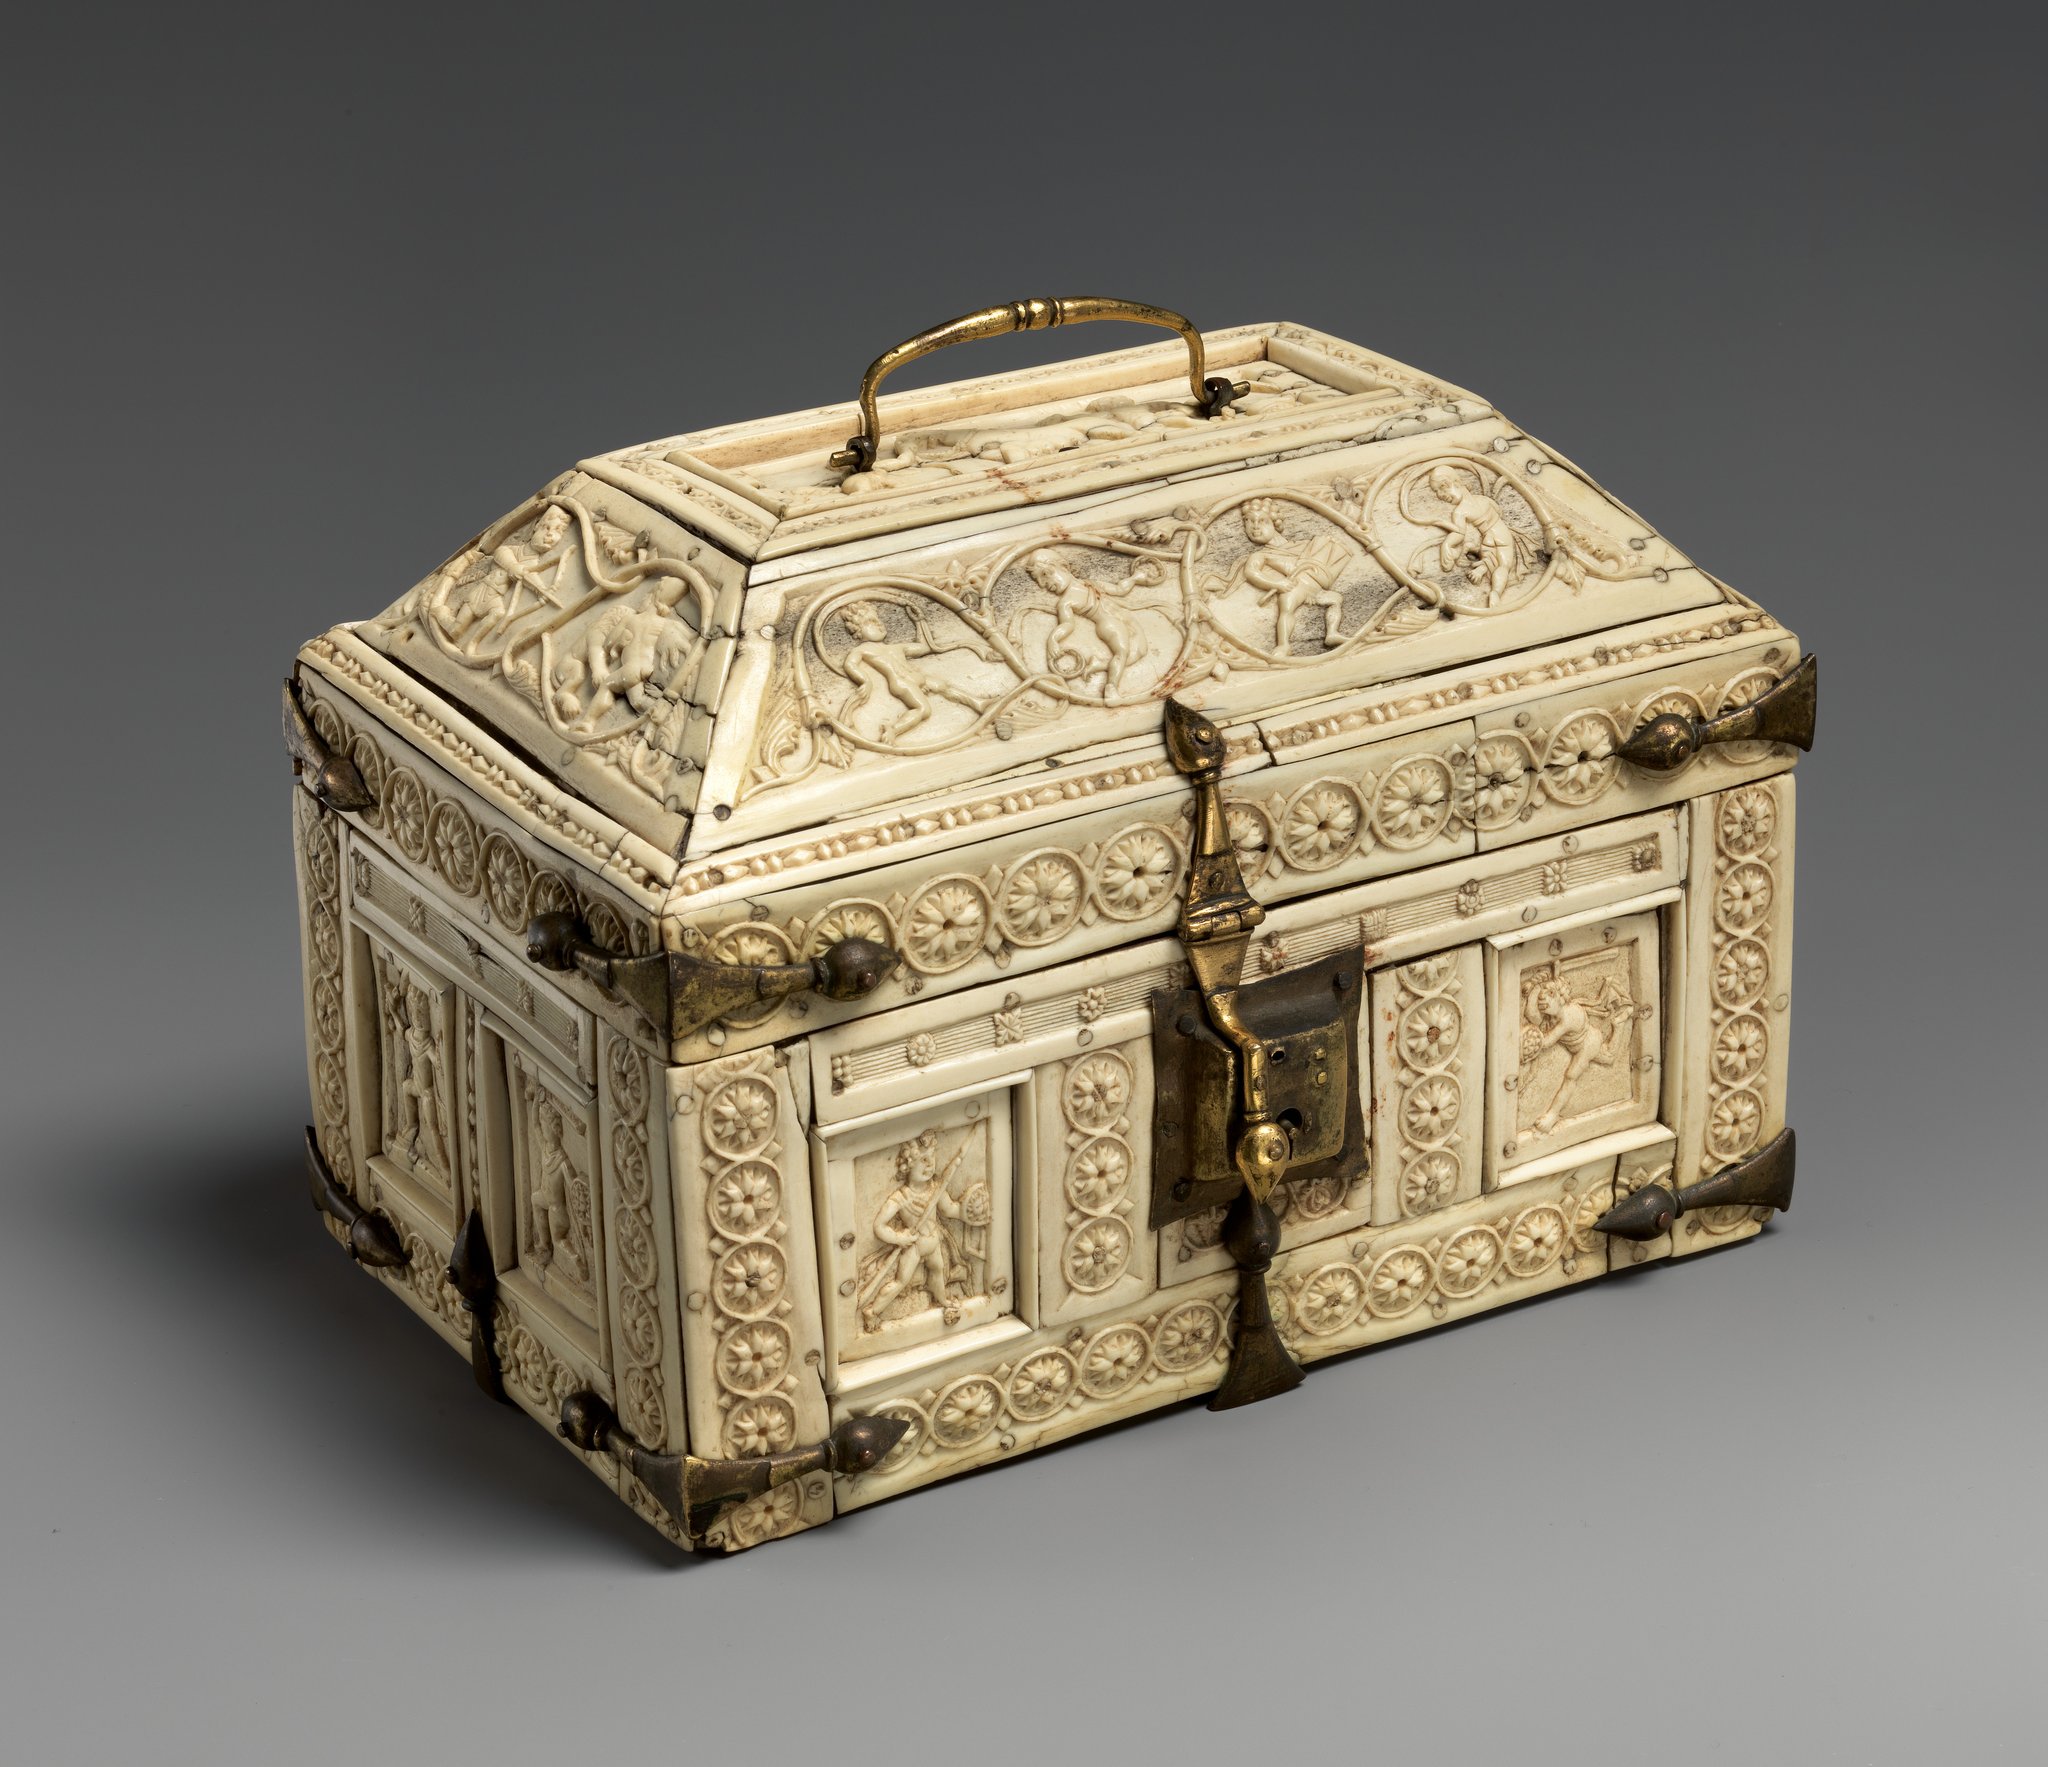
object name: casket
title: Casket with Warriors and Dancers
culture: byzantine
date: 1001-1100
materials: bone, gilt copper, ivory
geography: constantinople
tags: animals,men,dancers